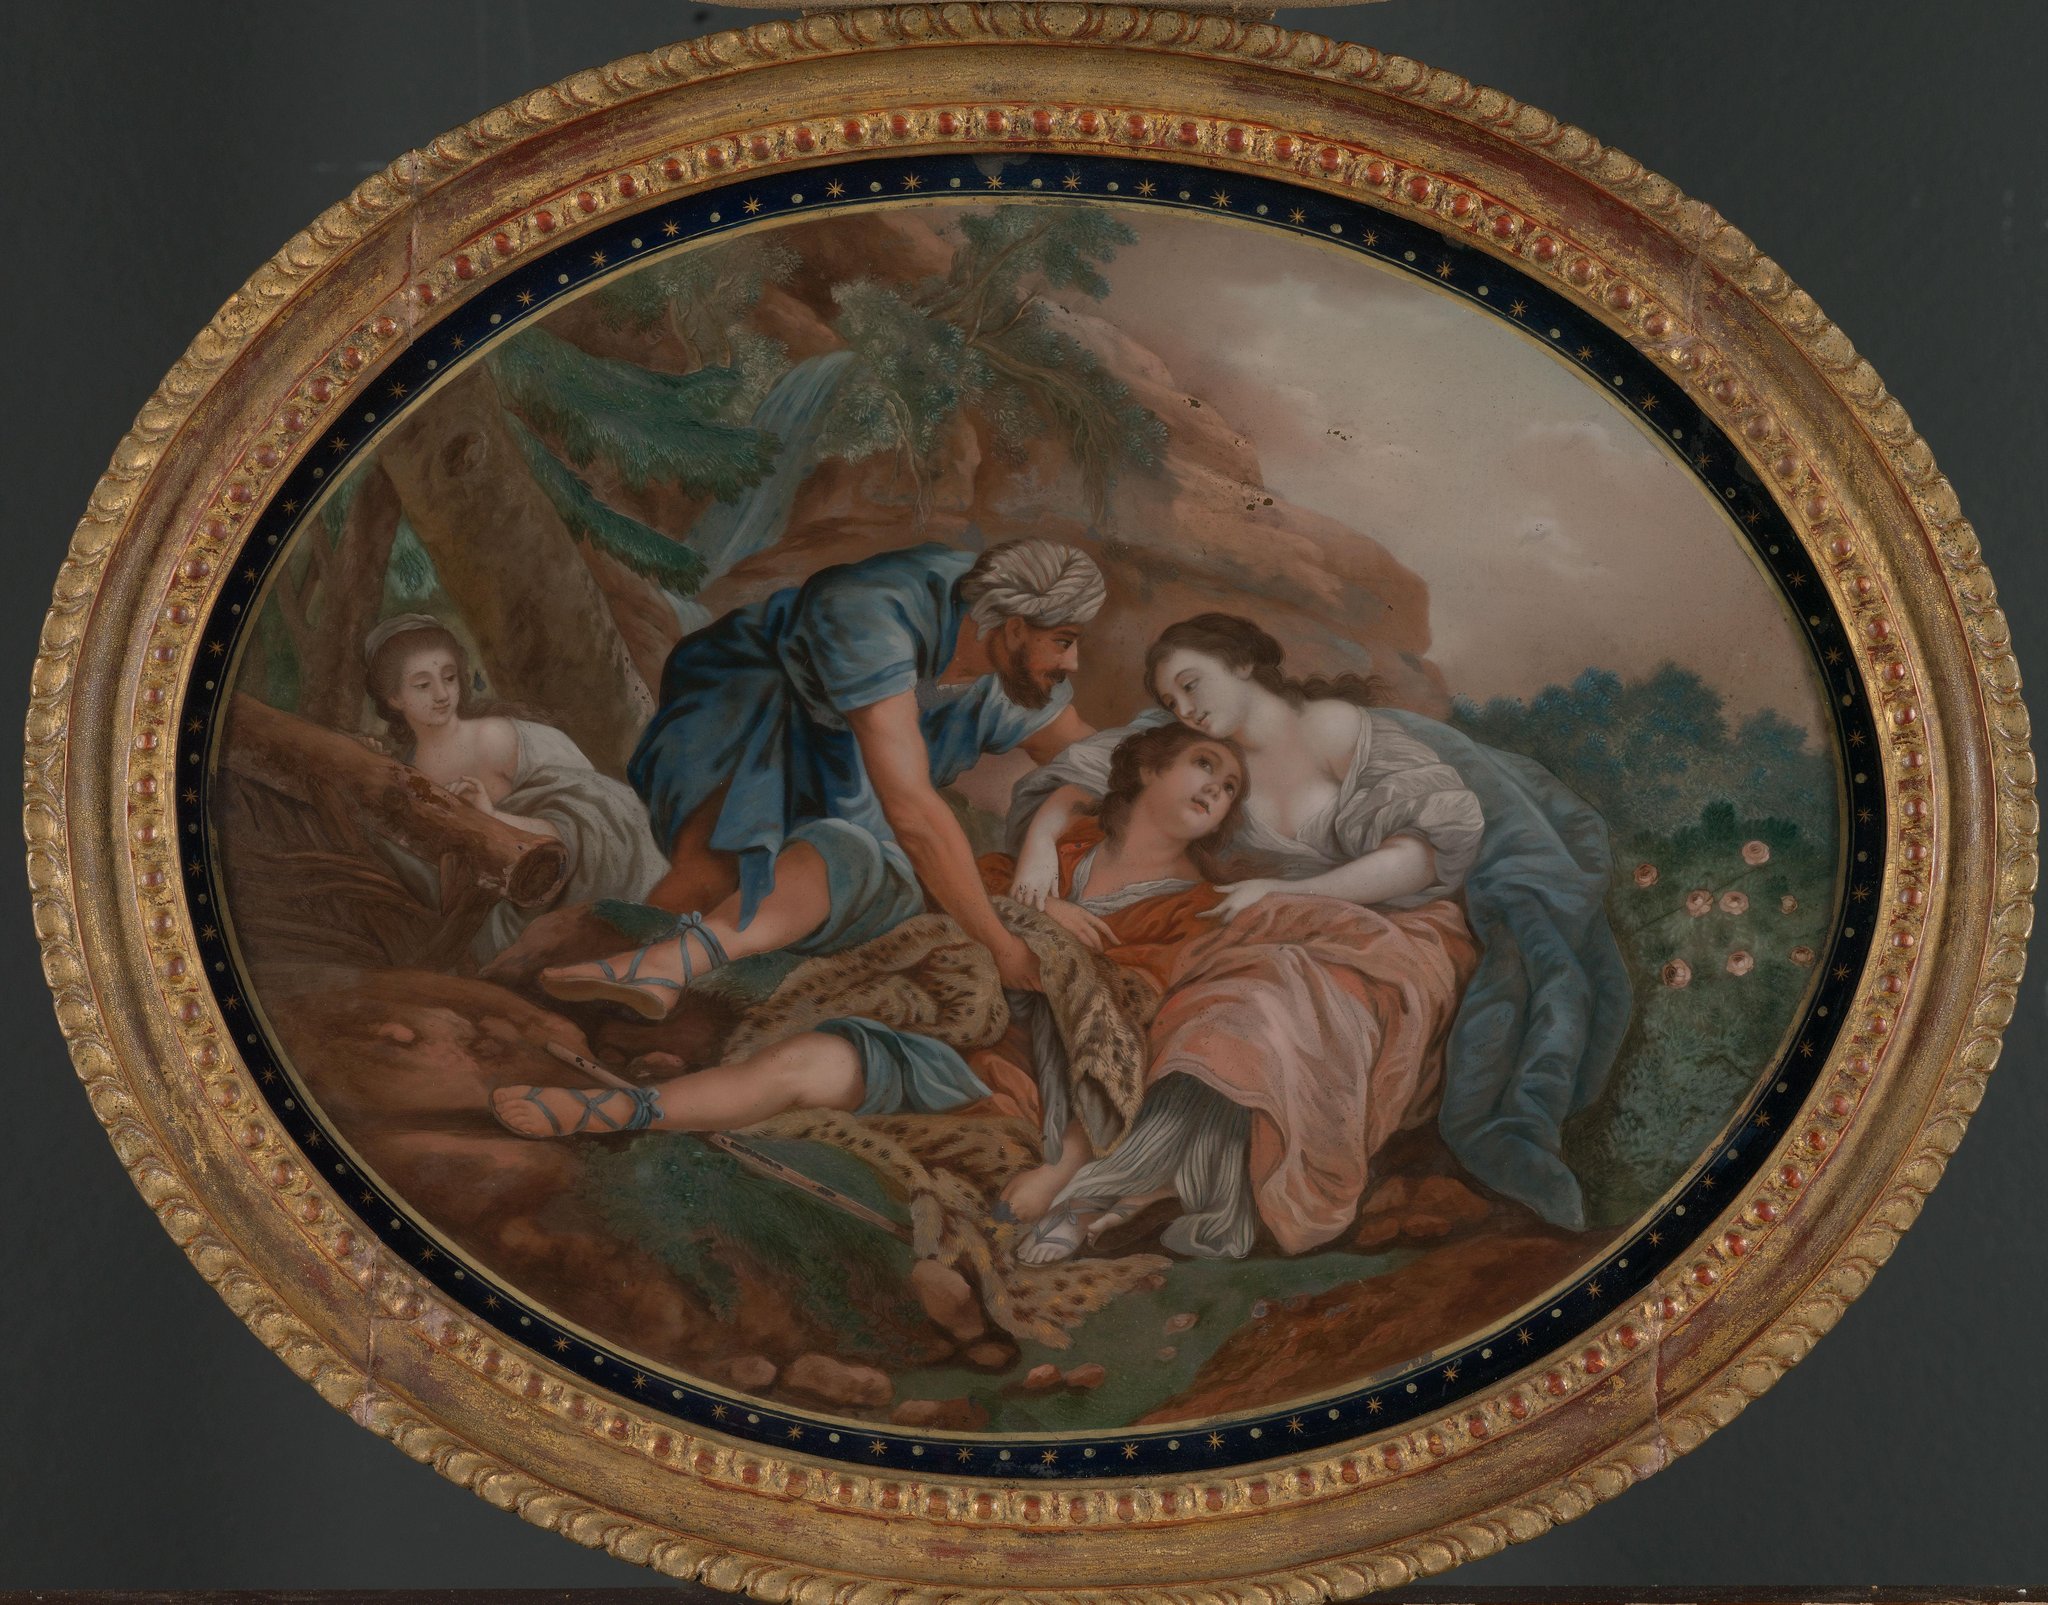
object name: reverse painting on glass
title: Fête galante scene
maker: Anonymous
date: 1795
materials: glass, oil, paint, wood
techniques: cutting, gilding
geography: guangdong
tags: amsterdam, (scenes from) specific works of literature: tasso, aminta, head-gear: turban, pastorals, arcadian scenes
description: Ovale achterglasschildering met drie dames en een heer in een landschap die samen een scène verbeelden uit het toneelstuk L'Aminta van Torquato Tasso: Aminte dans les bras de Sivie. Geschilderd naar een prent van Louis Simon Lempereur, naar een schilderij van François Boucher. De gesneden en vergulde lijst is origineel.